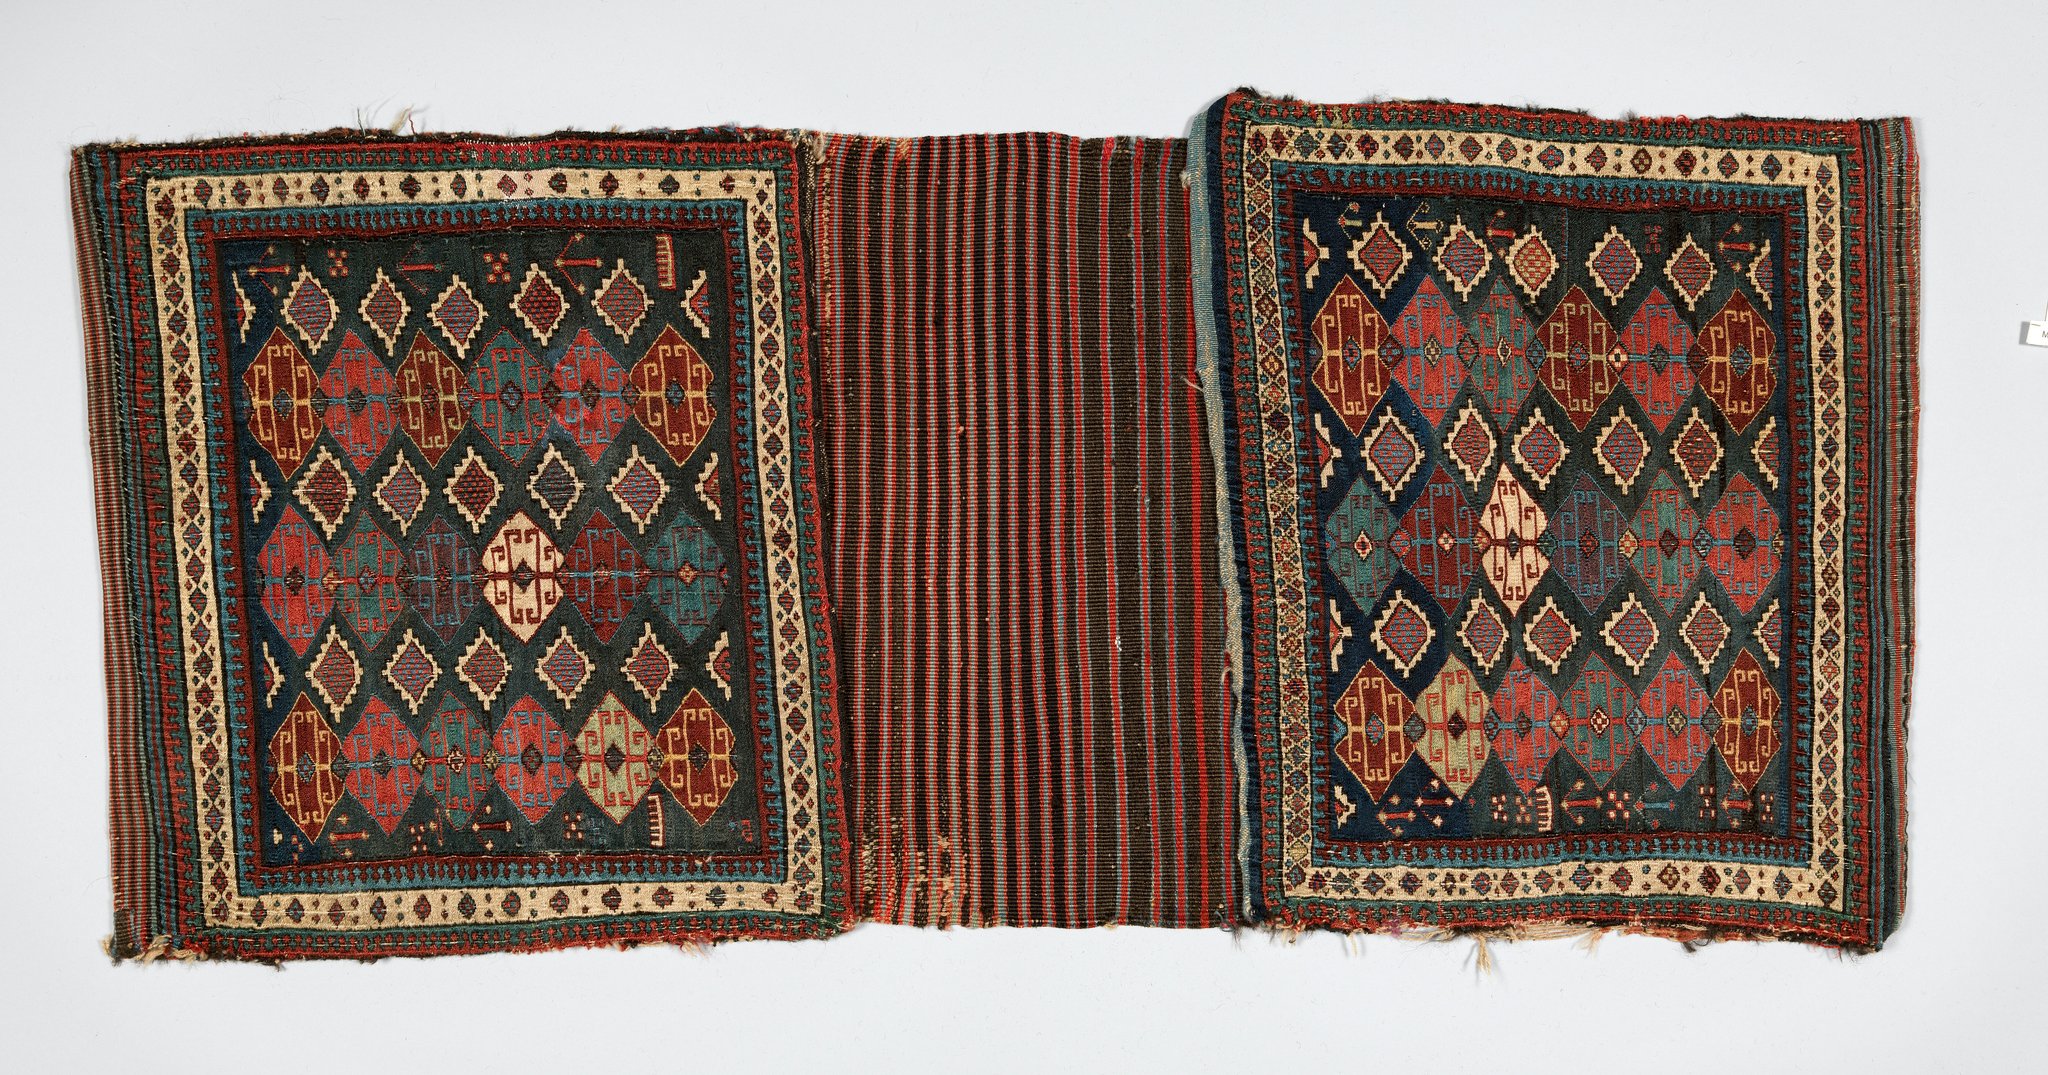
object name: saddle bag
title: Complete Double Saddle Bag (Khorjin)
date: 1801-1900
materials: wool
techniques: brocade, weave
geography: northwestern iran